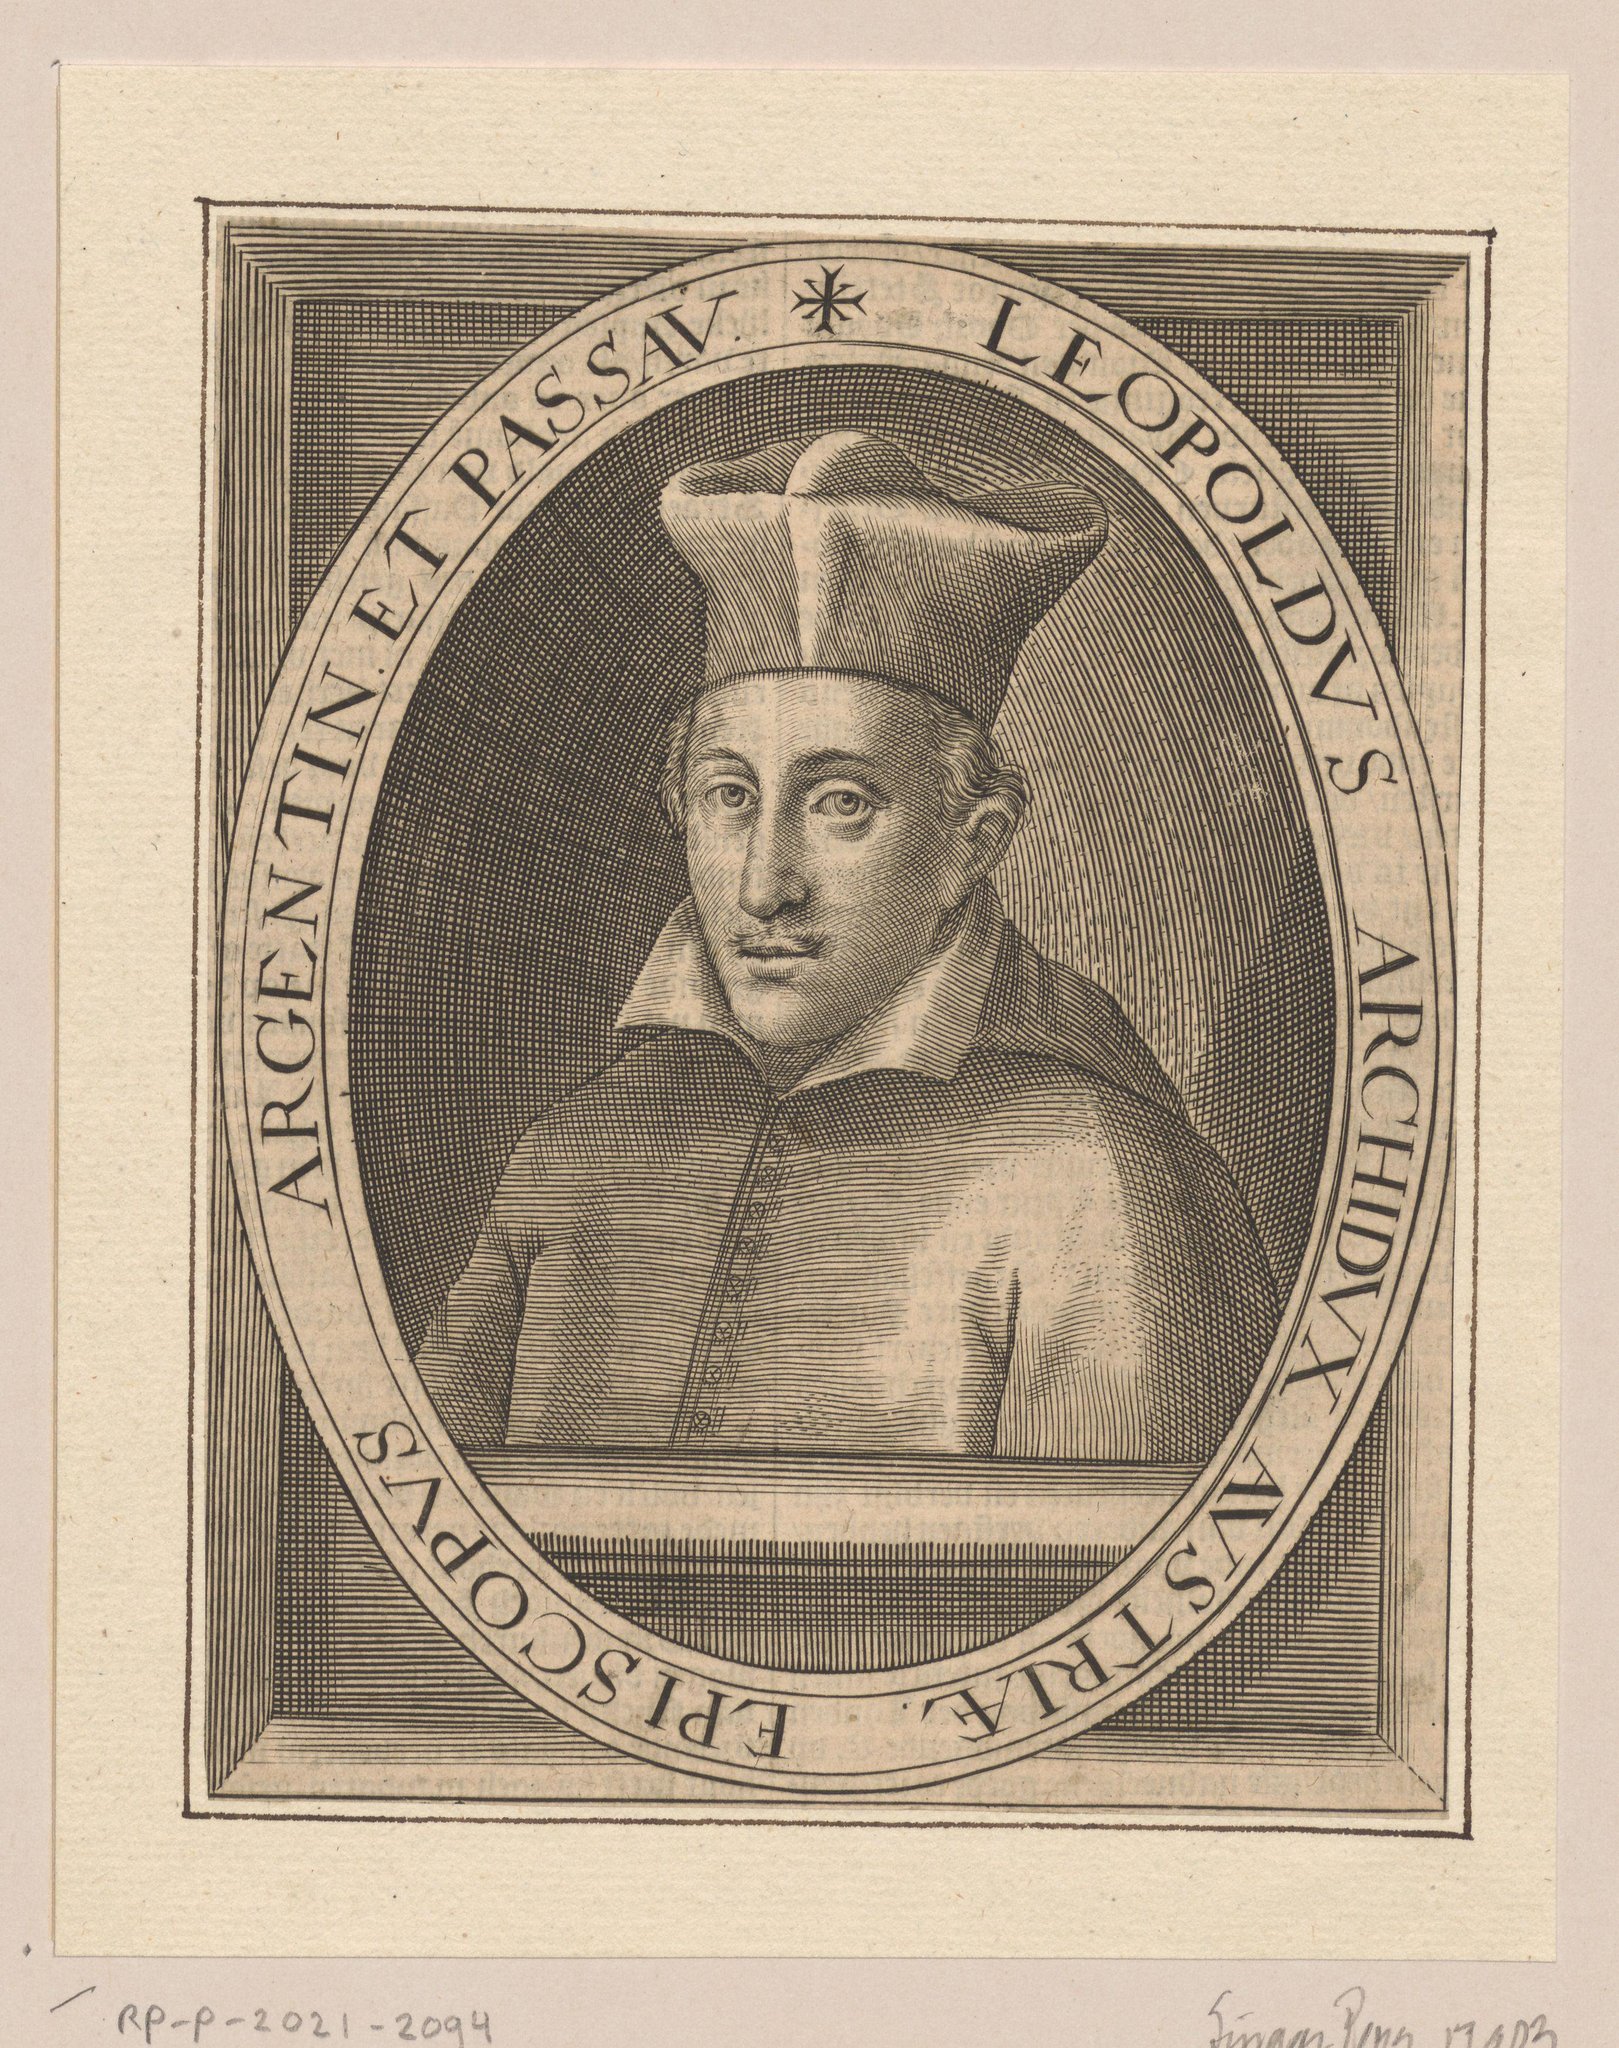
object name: book illustration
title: Portret van Leopold V, aartshertog van Oostenrijk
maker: Anonymous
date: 1623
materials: paper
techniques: engraving, letterpress printing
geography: northern netherlands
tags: leopold v (aartshertog van oostenrijk), archbishop, bishop, etc. (roman catholic), historical persons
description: De prent is in ieder geval gebruikt in: Meteren, Emanuel van. Historie der Neder-landscher ende haerder na-buren oorlogen (...). Den Haag: weduwe van Hillebrant Jacobsz. van Wouw, 1623. Omdat de prent op een papier is geplakt en de tekst op het verso hierdoor niet zichtbaar is, is niet na te gaan uit welke publicatie dit exemplaar komt. Vermoedelijk is de prent ook in andere edities en vertalingen van Van Meterens 'Nederlandsche Historien' gebruikt.